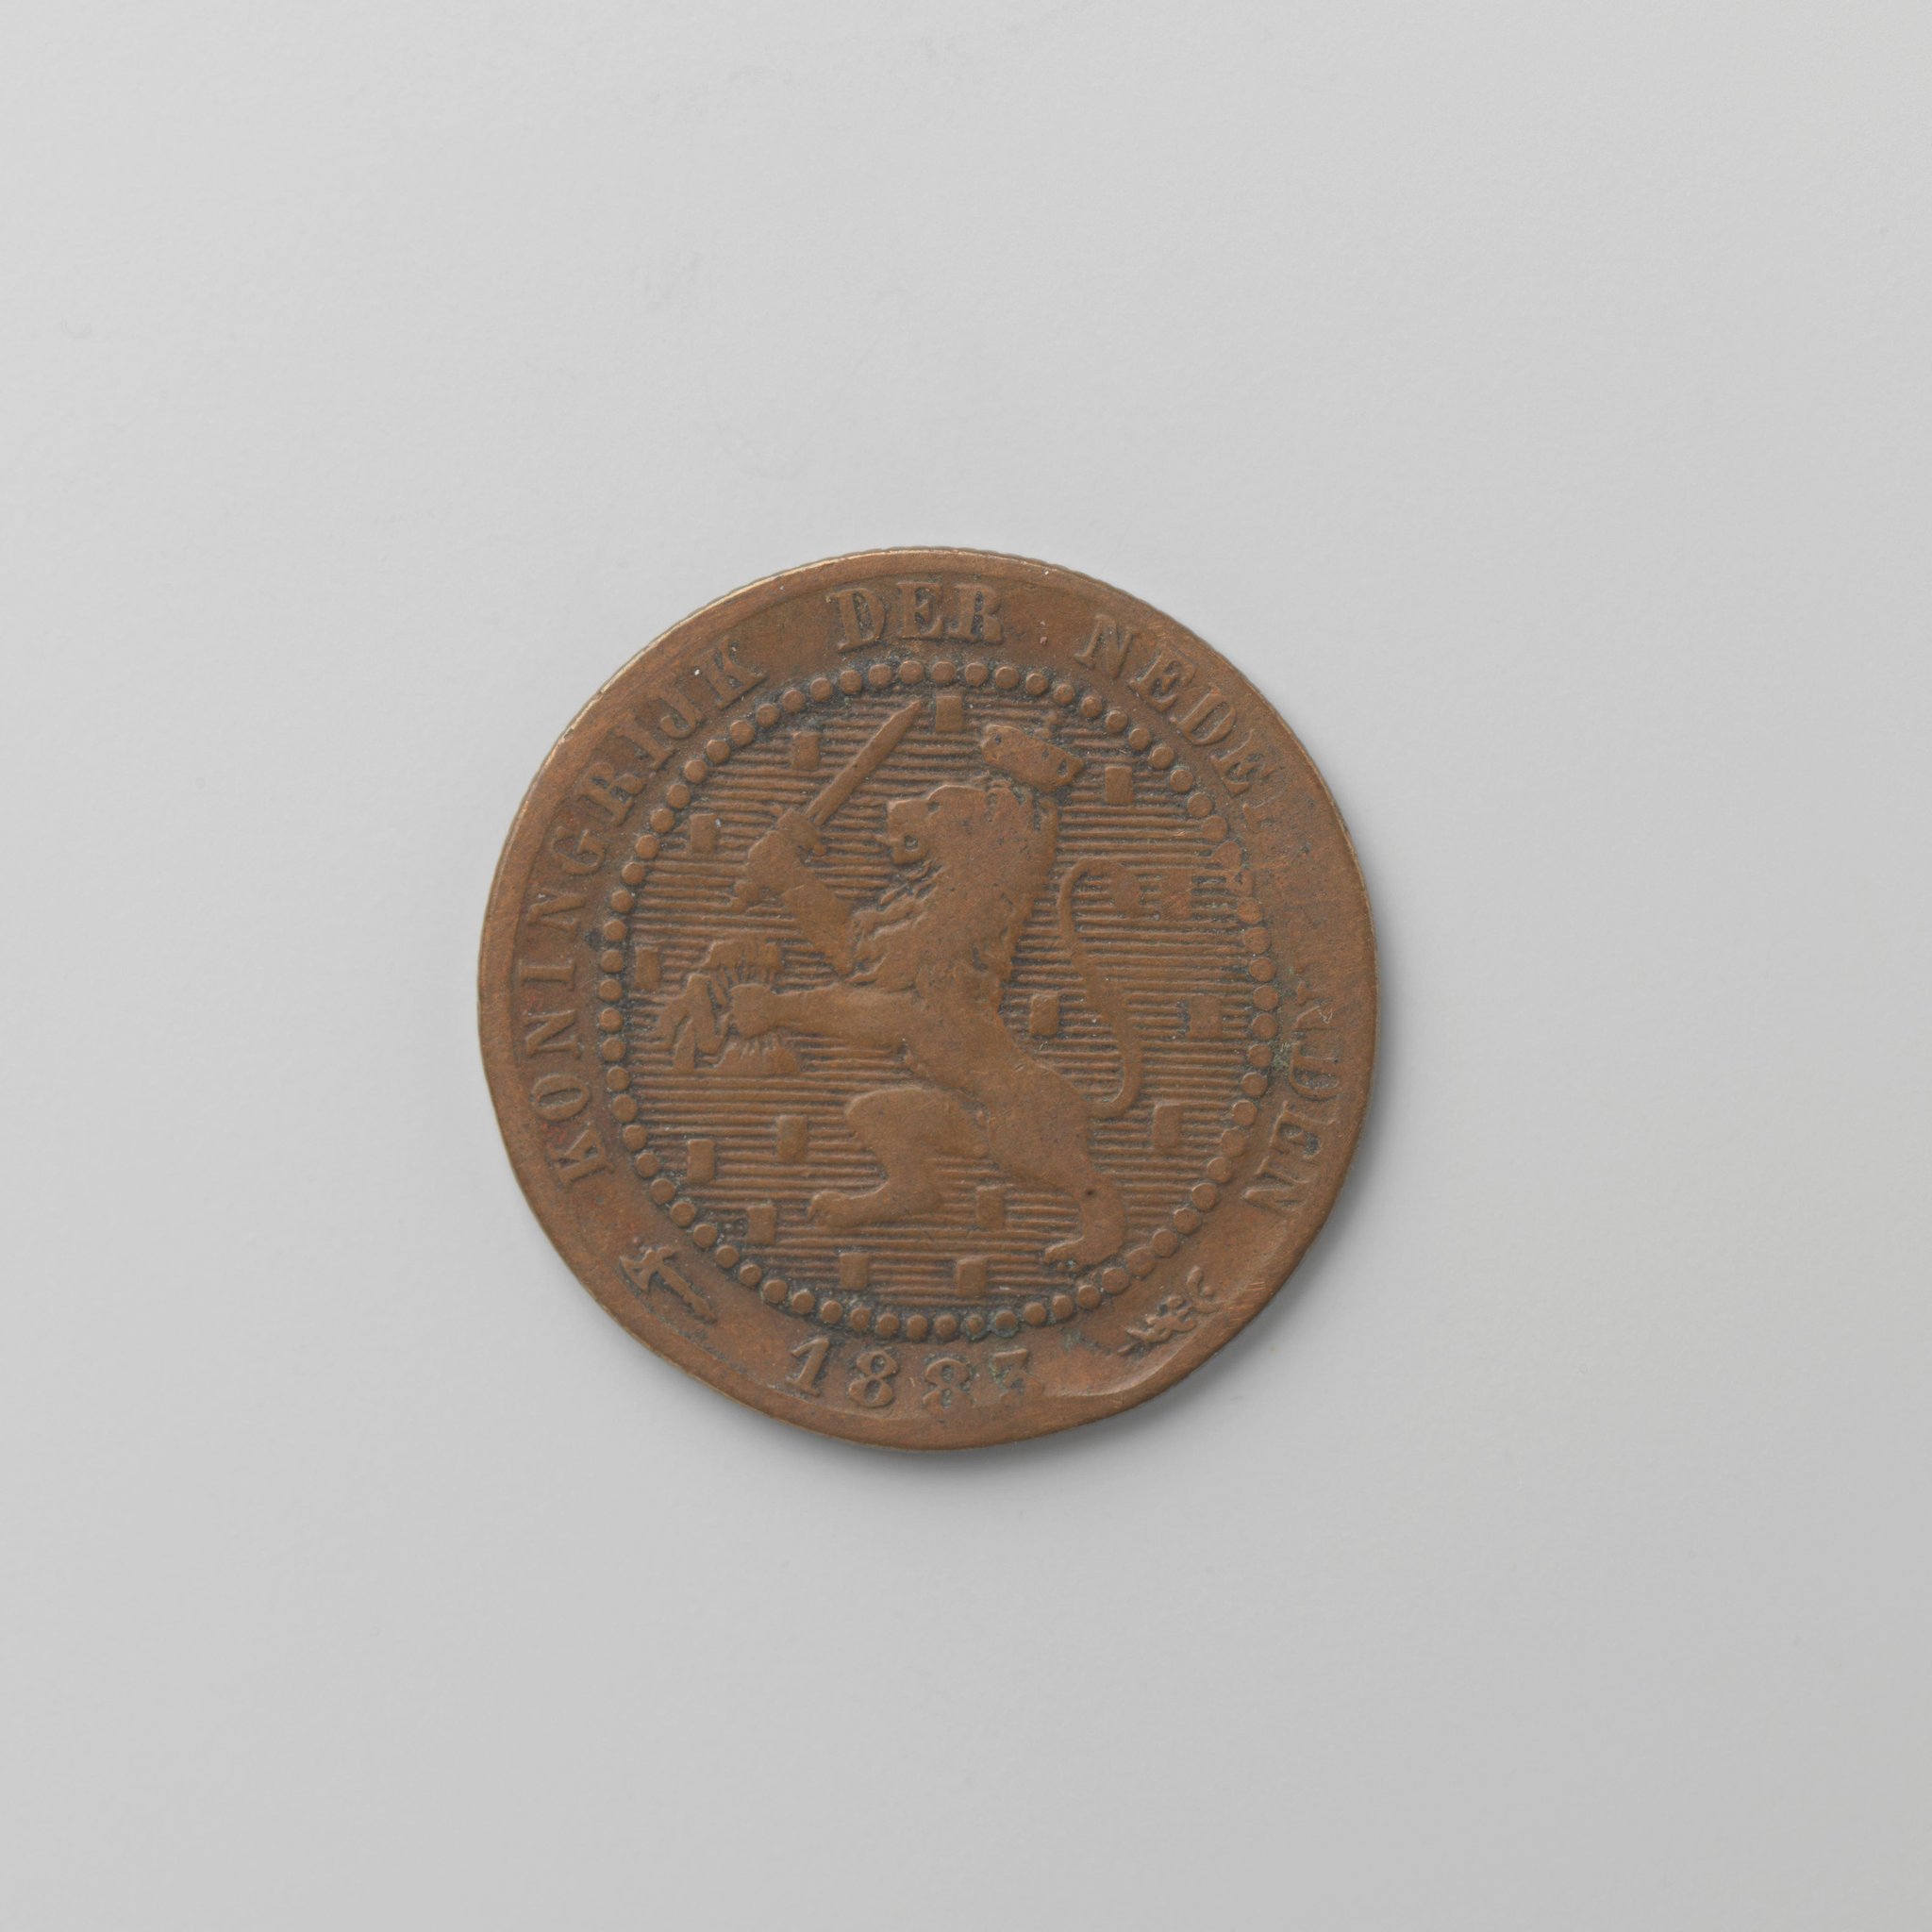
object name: coin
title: Nederlandse cent, 1883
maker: willem iii (koning der nederlanden)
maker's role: koning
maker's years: 1817-1890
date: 1883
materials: bronze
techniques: striking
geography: utrecht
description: Bronzen munt. Voorzijde: in een veld rijkswapen. Jaartal onderaan in omschrift. Keerzijde: binnen twee samengebonden oranjetakken waarde-aanduiding 1 cent. Kartelrand.